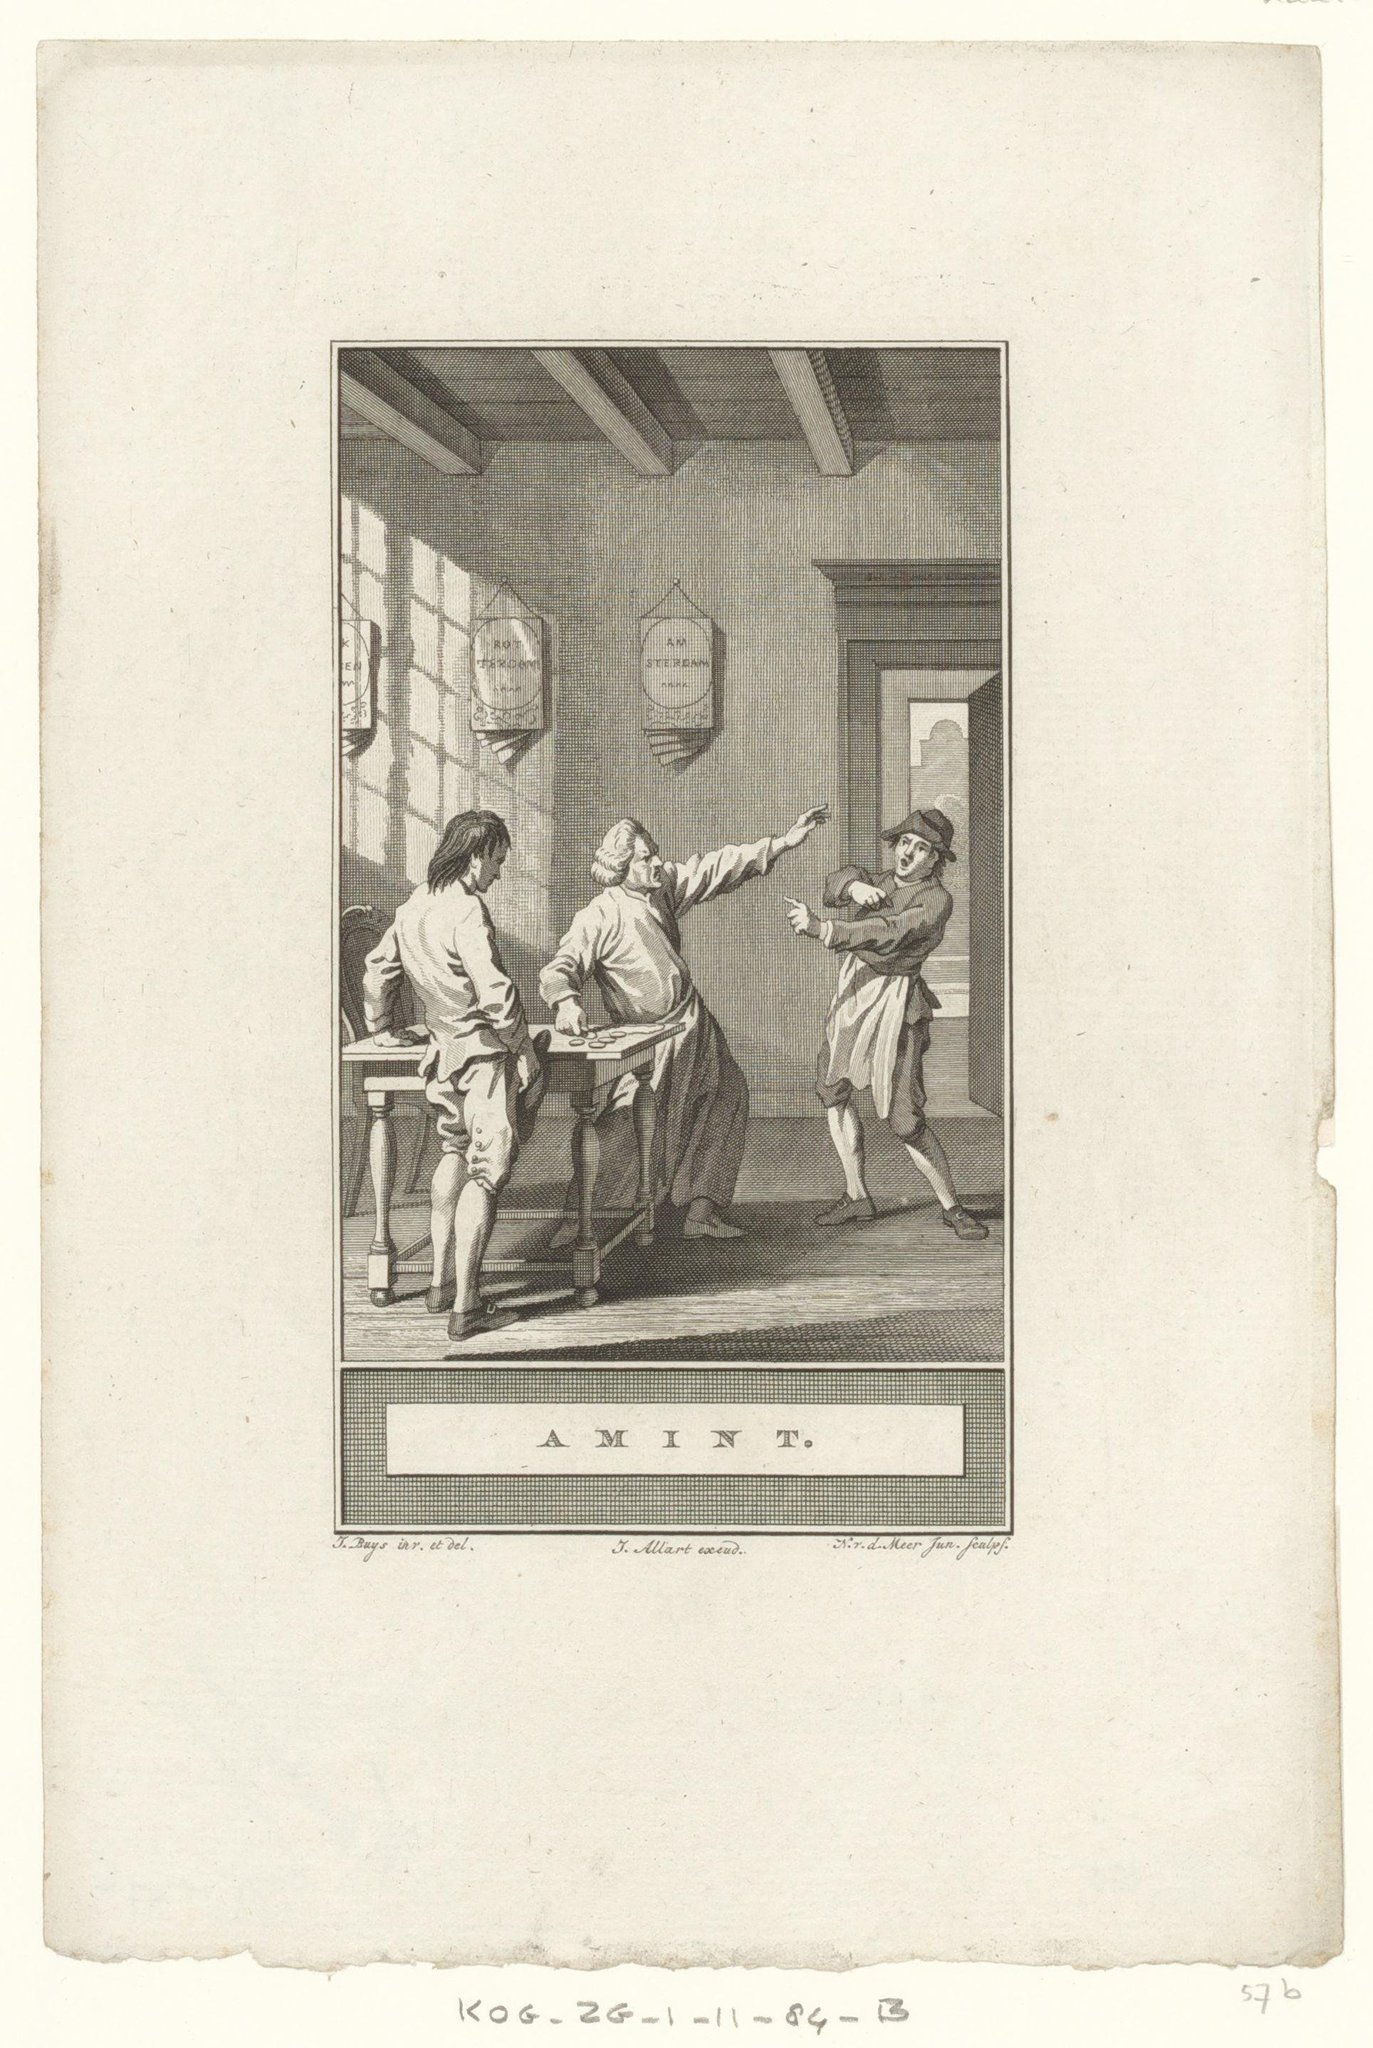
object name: print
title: Amint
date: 1773-1816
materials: paper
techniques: engraving, etching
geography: amsterdam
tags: money-changer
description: Drie mannen in een wisselkantoor. Twee mannen schreeuwen en maken boze armbewegingen. Een van de mannen telt de munten op tafel. Onderwerpsrubrieken binnen de Atlas Zeden en Gewoonten: Handel, nijverheid en verkeer, Koophandel, Veilingen, Makelaardij en Verzekeringswezen. Kamers te huur.